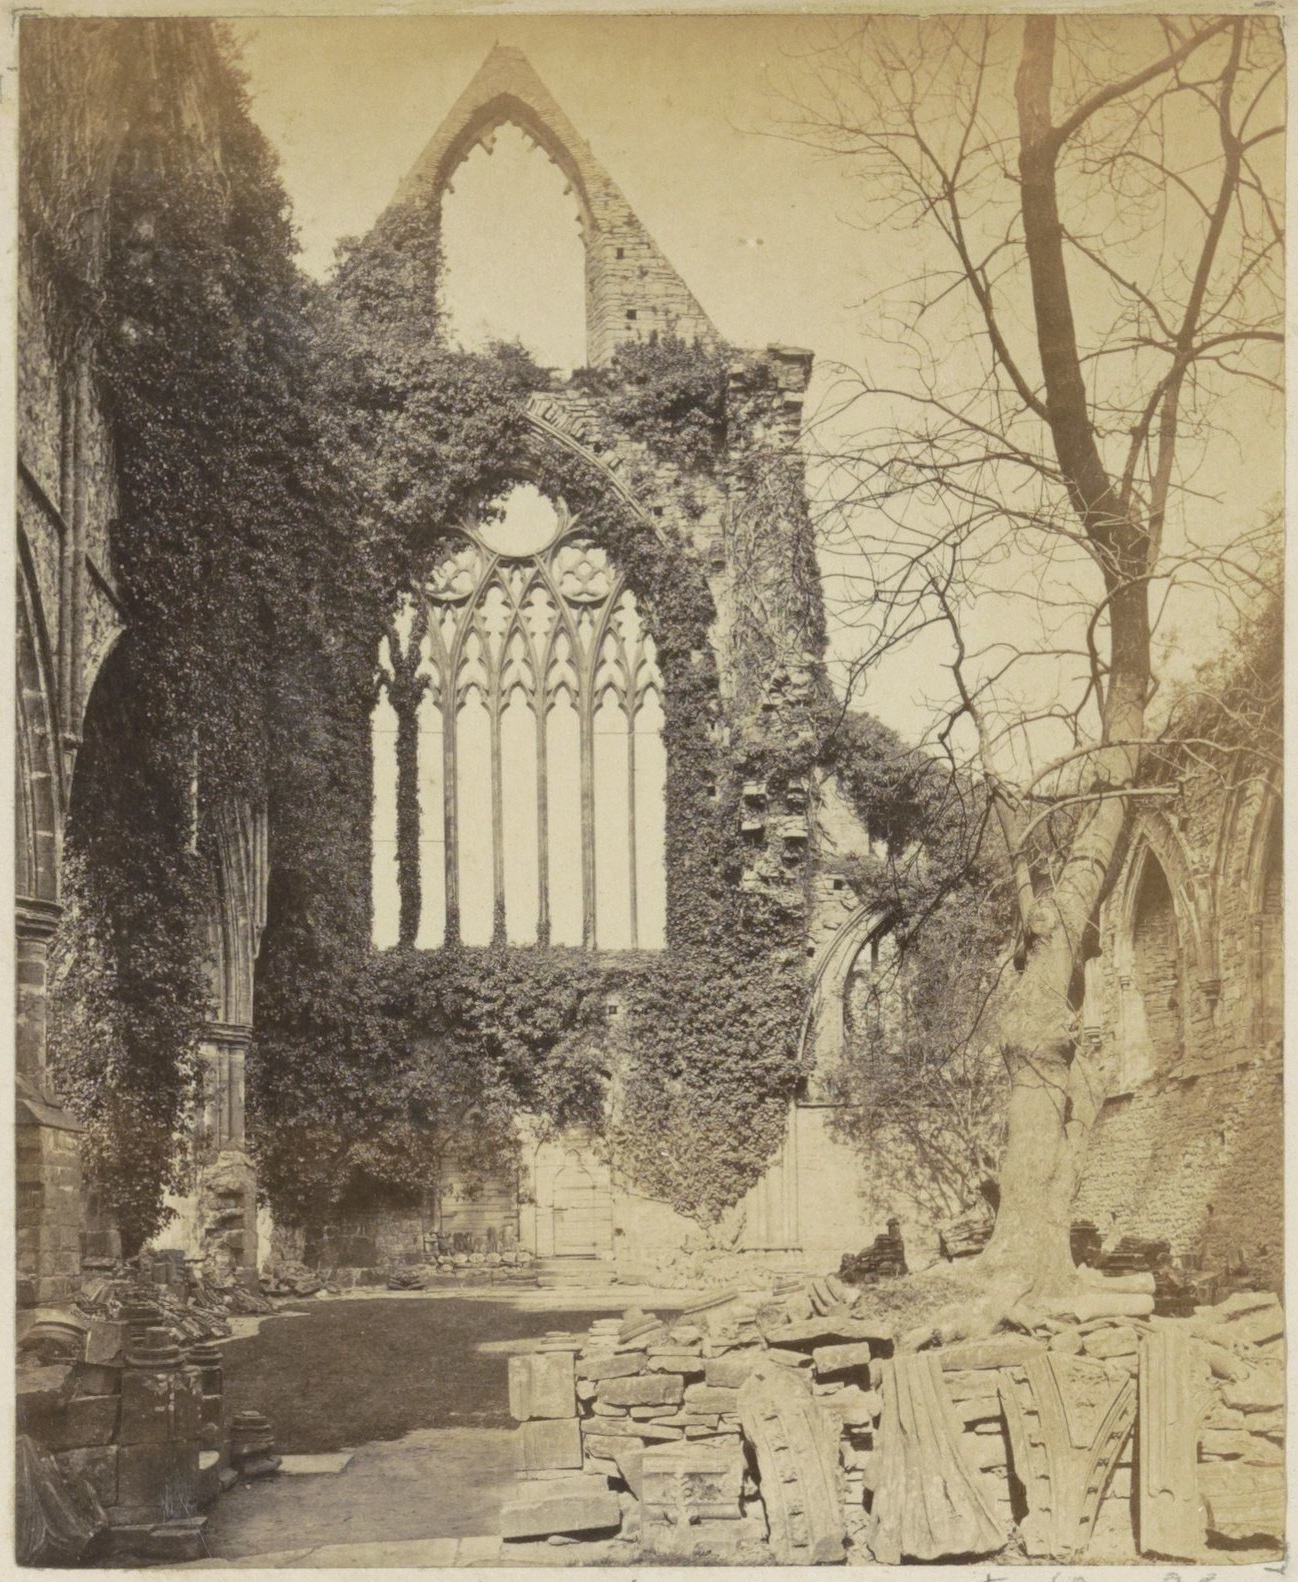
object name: photograph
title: Ruïne van Tintern Abbey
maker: Anonymous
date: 1850-1870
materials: paper, photographic support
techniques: albumen print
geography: tintern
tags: ruin of a dwelling, house, castle, etc.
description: Onderdeel van Album met foto's van bezienswaardigheden en landschappen in Engeland en van kunst.